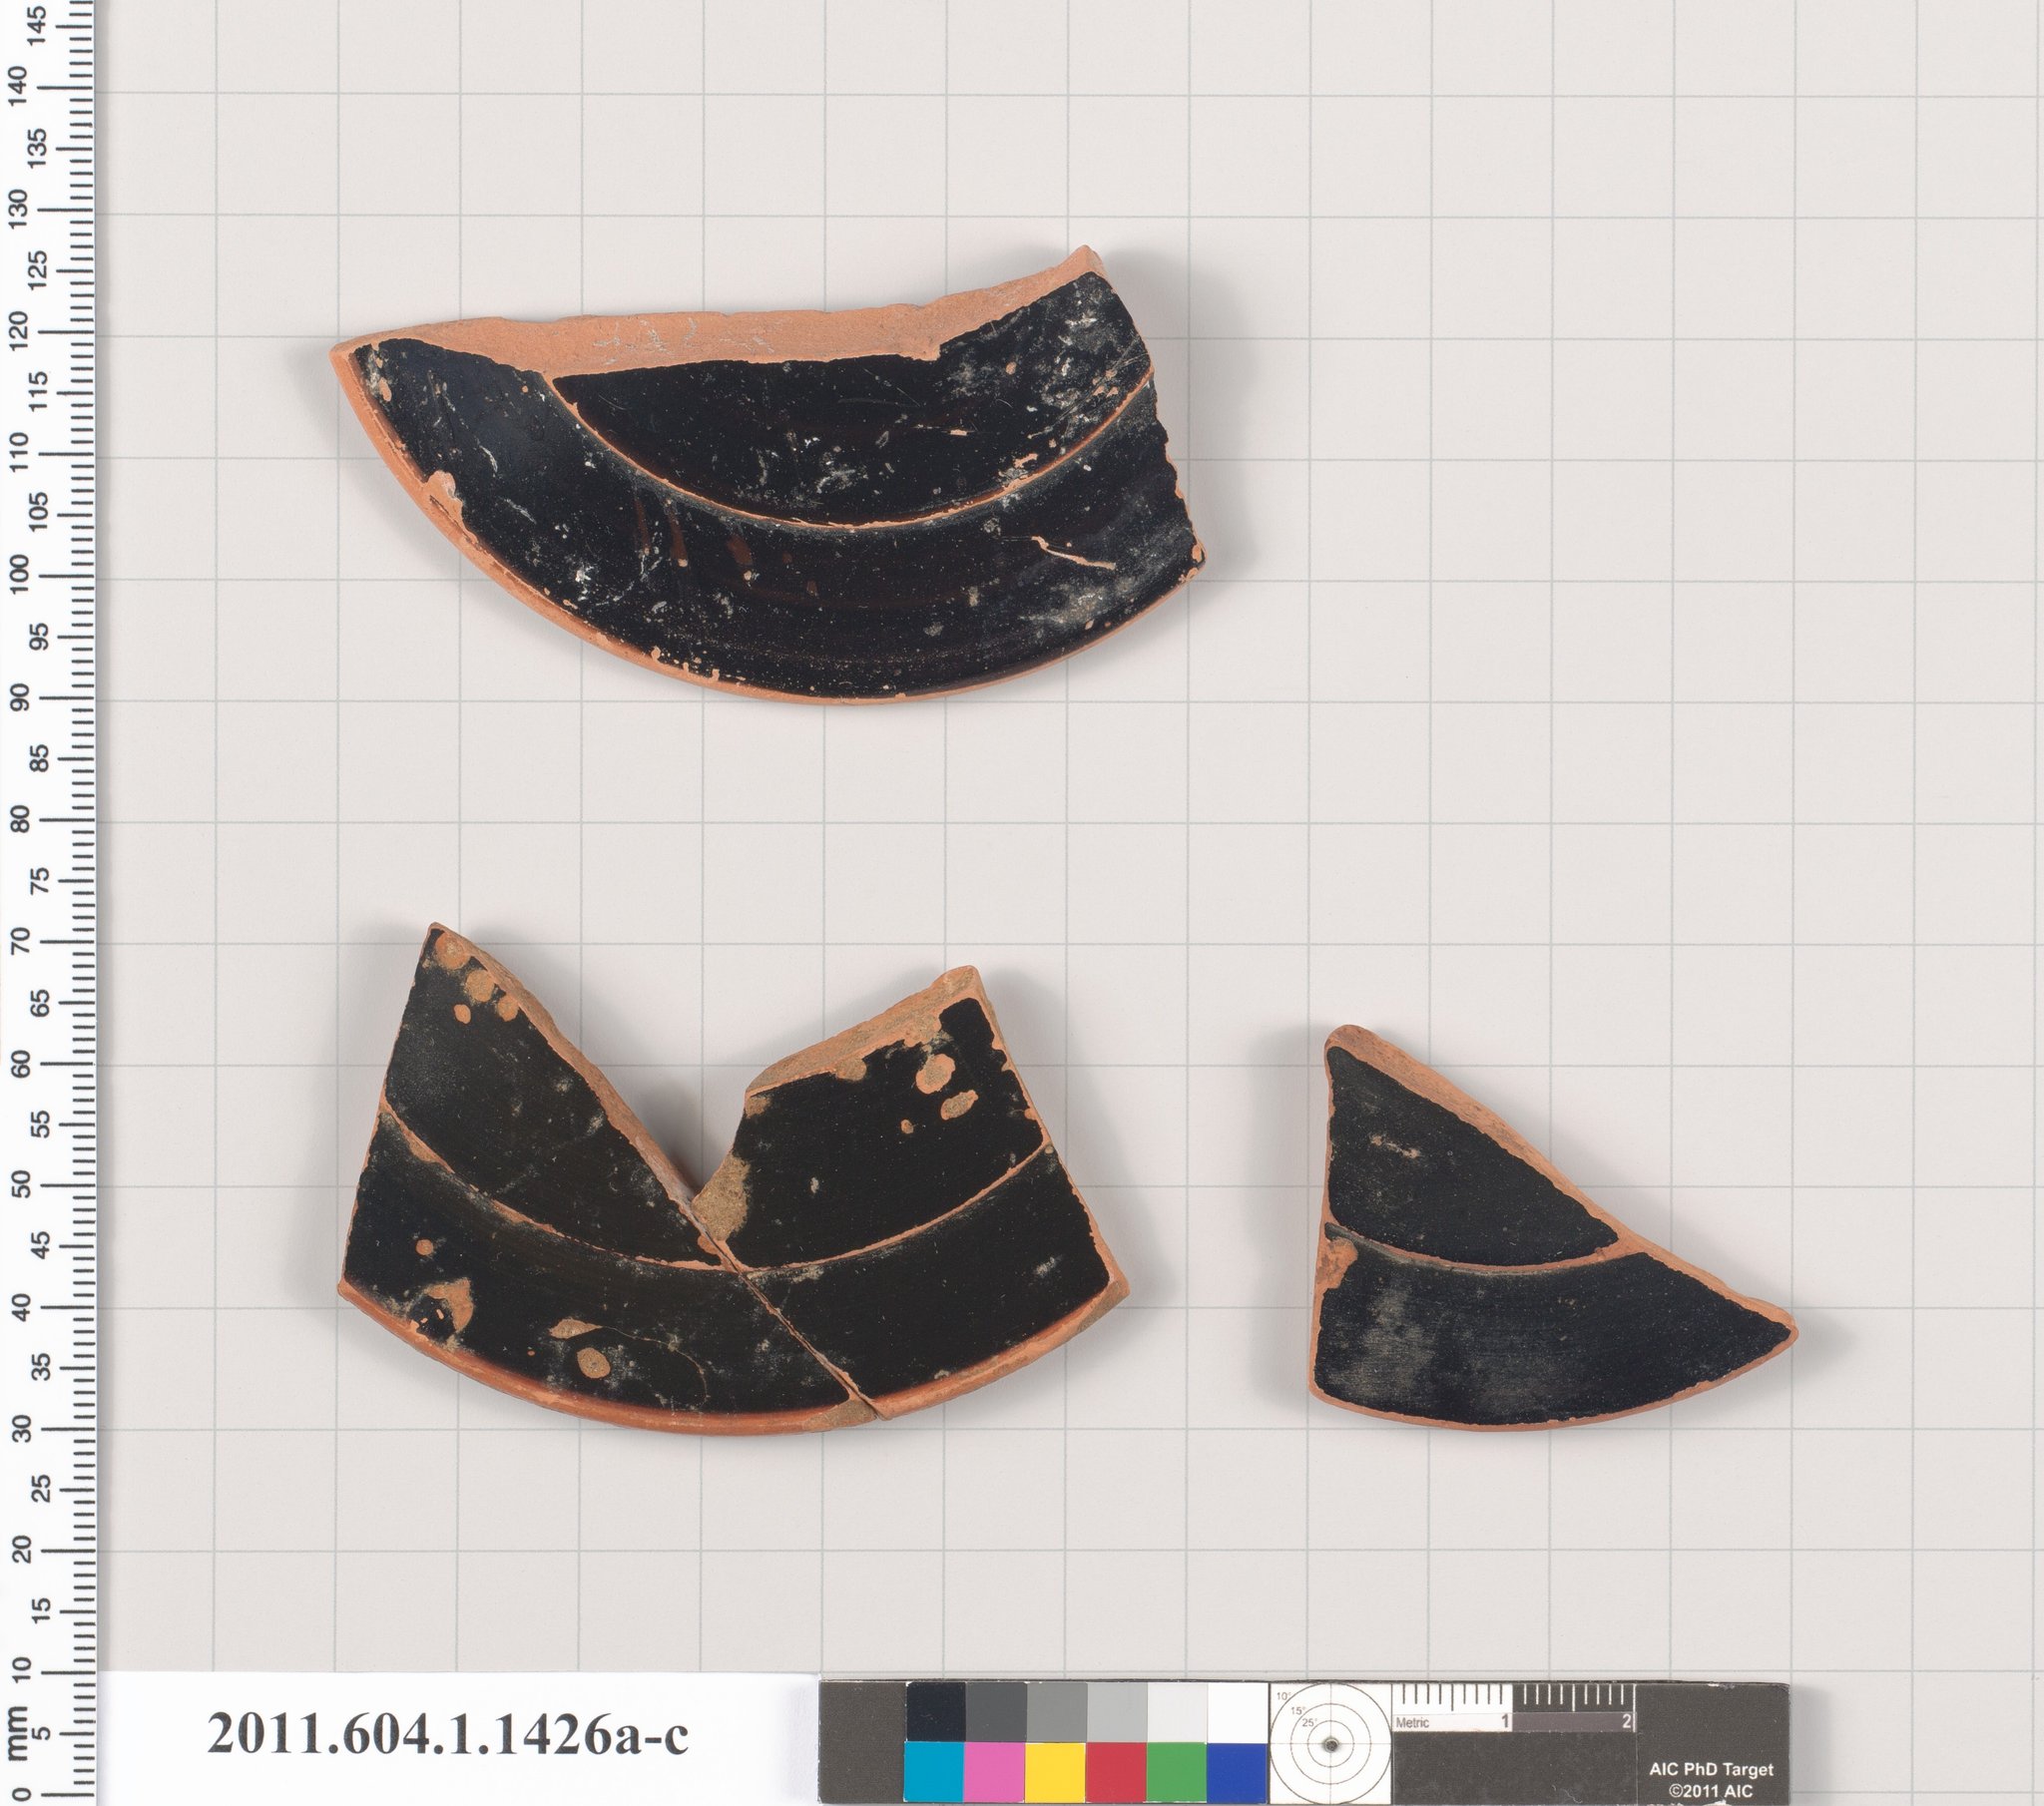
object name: kylix fragment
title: Terracotta fragments of kylikes (drinking cups)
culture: greek, attic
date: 500-401 BCE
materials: terracotta